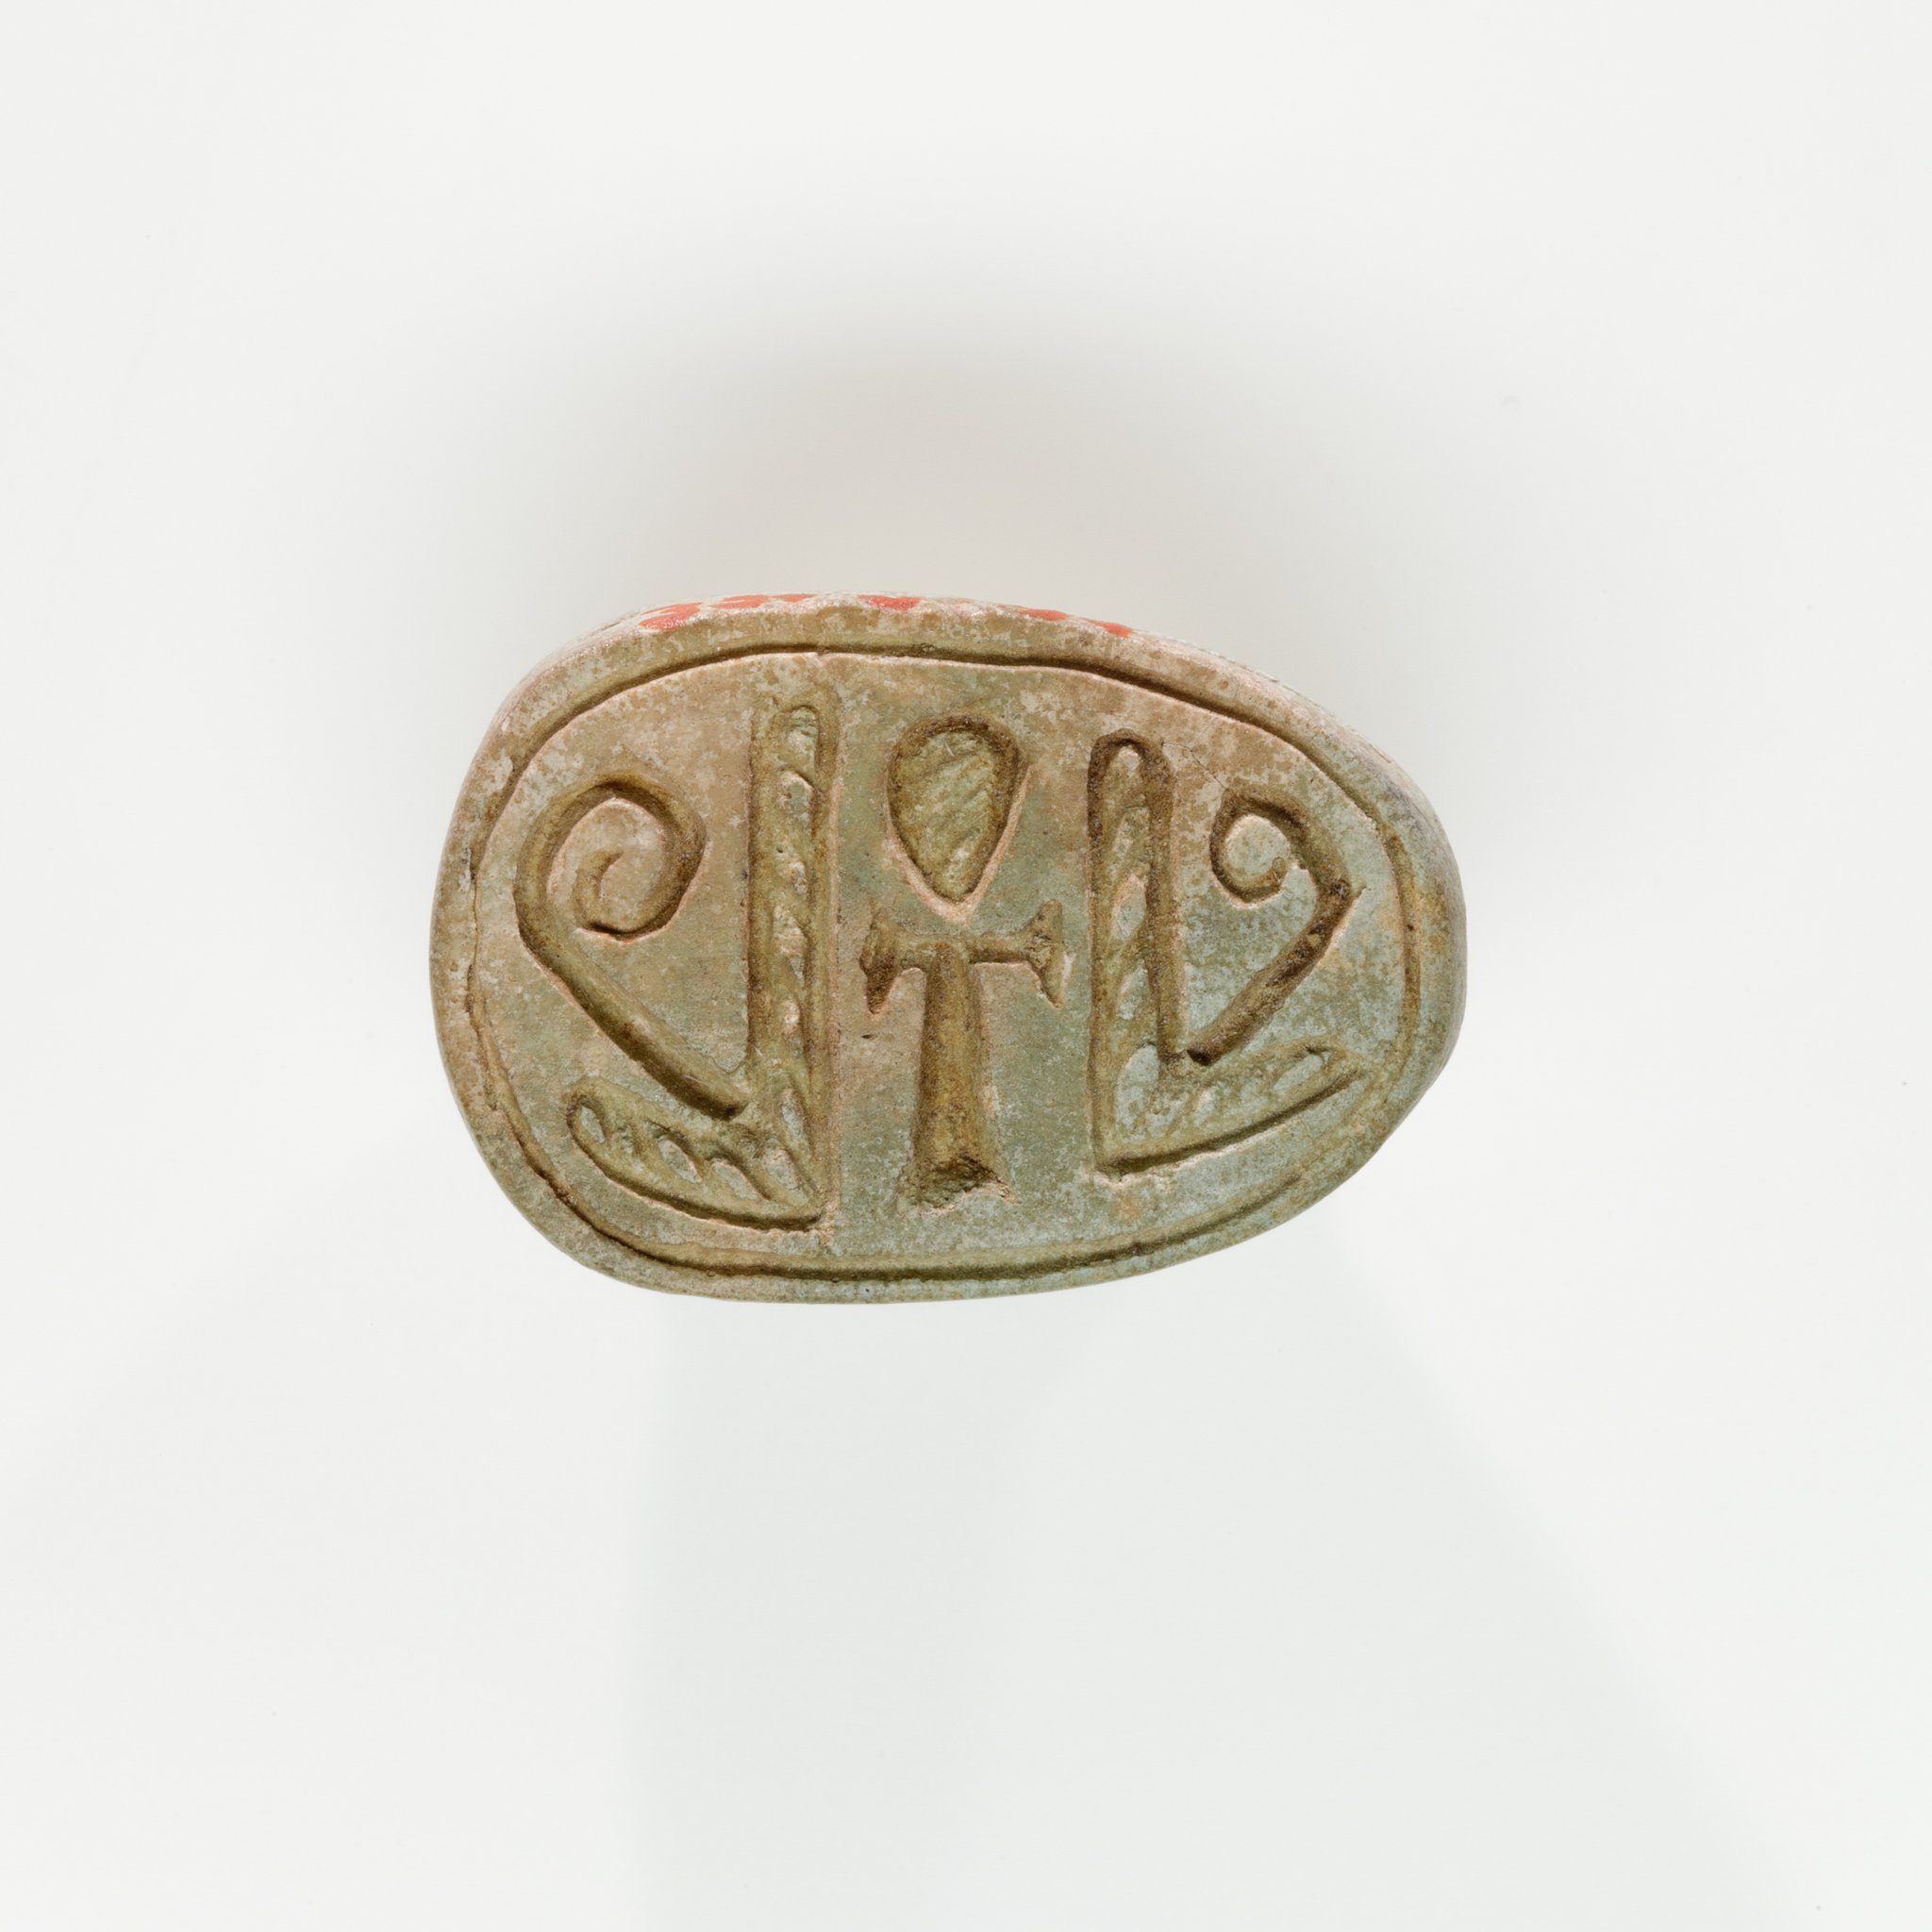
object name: scarab, red crown, ankh, rennefer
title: Scarab from Rennefer's Burial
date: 1504-1447 BCE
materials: faience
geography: egypt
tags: hieroglyphs,scarabs